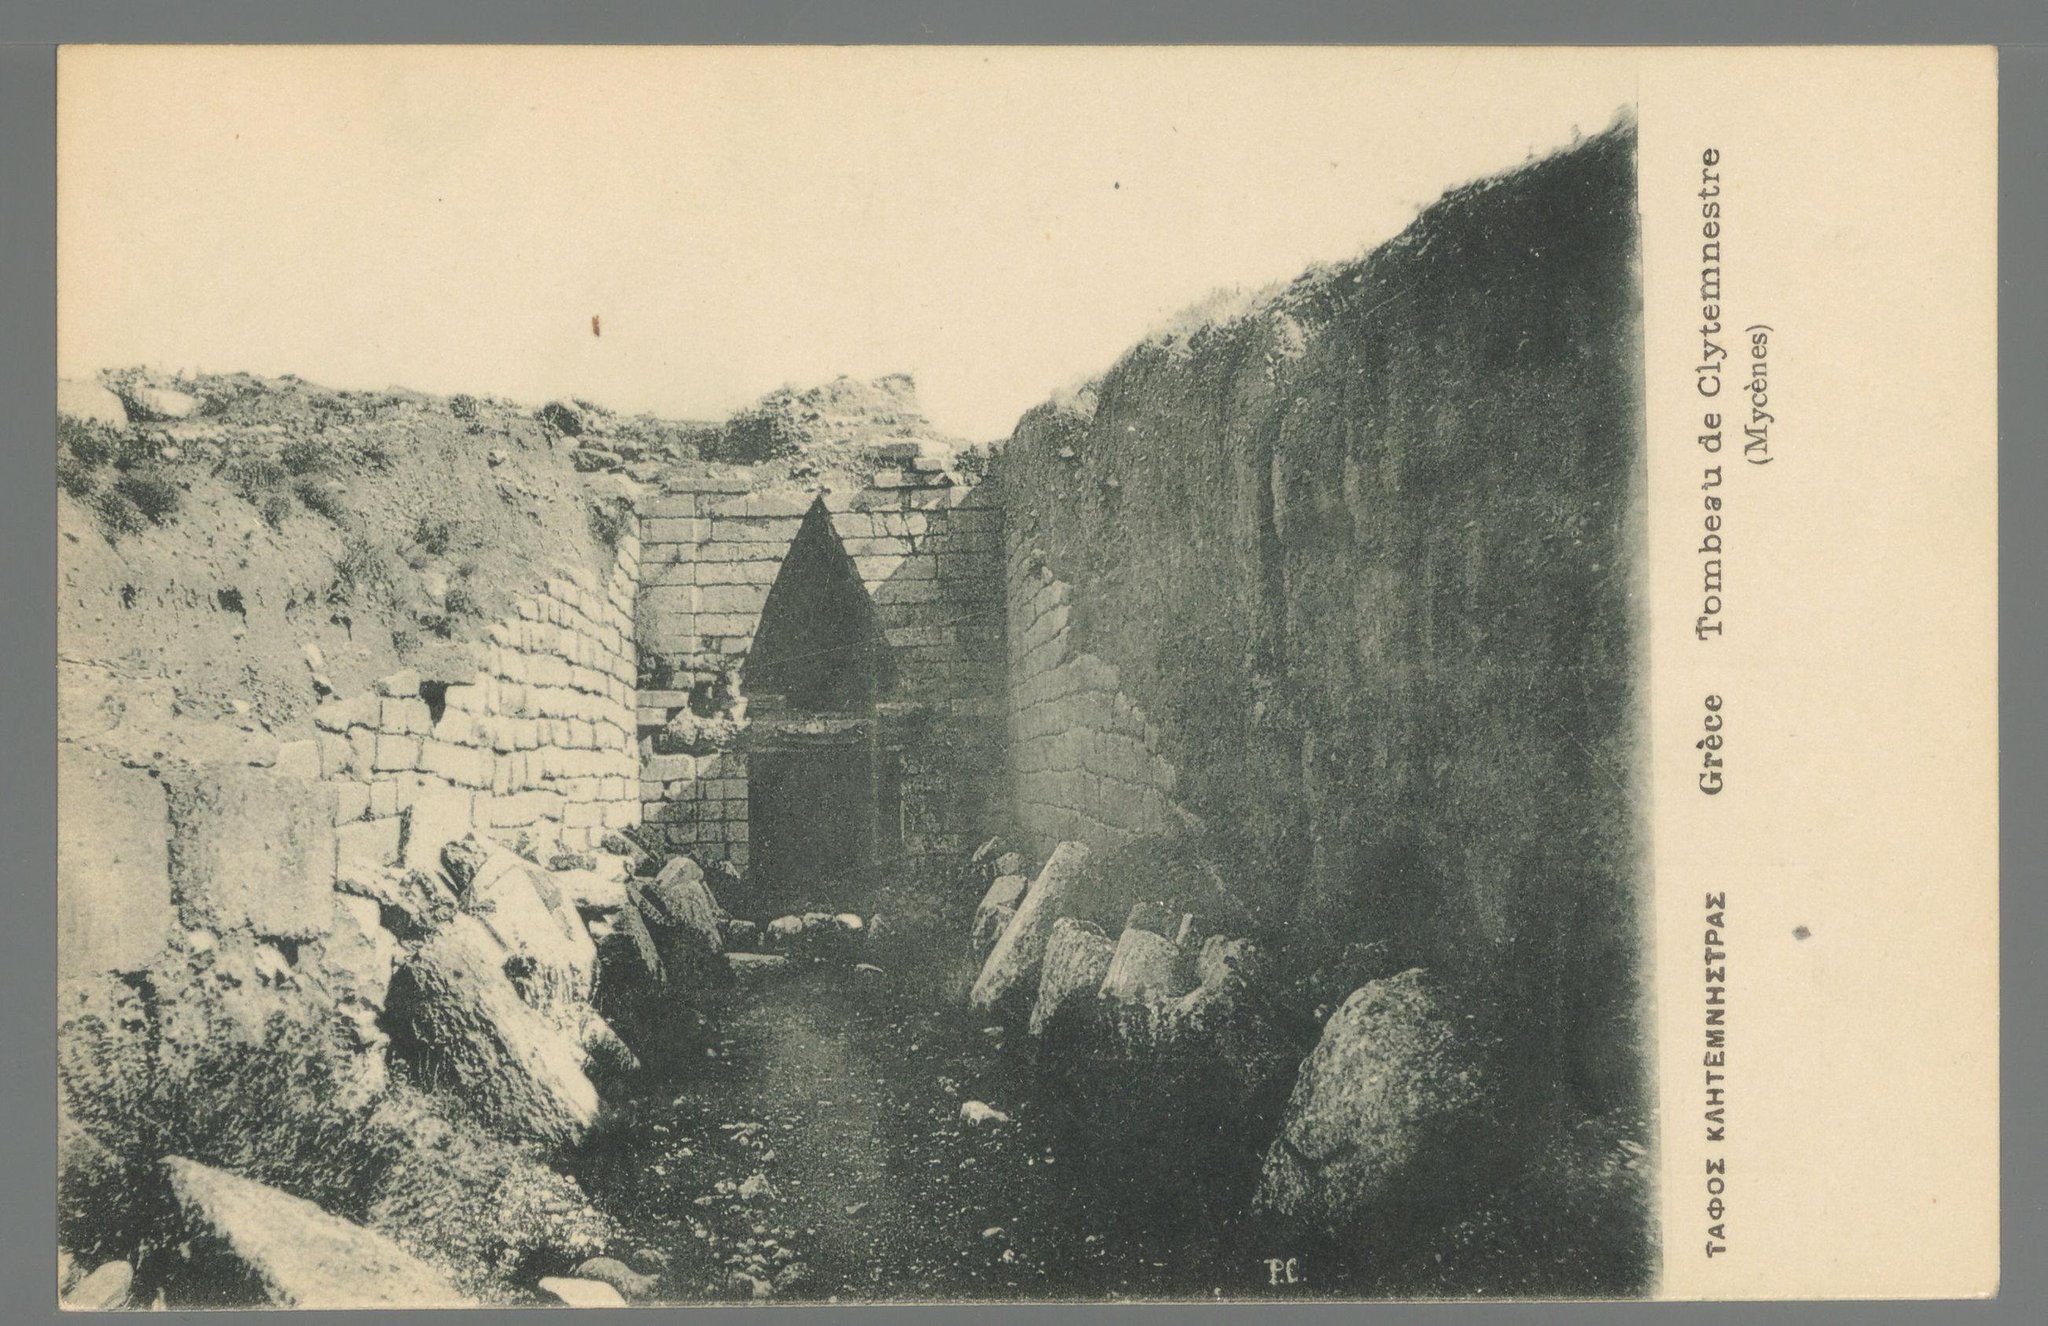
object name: photomechanical print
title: Grèce. Tombeau de Clytemnestre (Mycènes)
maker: Anonymous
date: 1906-1930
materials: cardboard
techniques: photograph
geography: mycene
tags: grave, tomb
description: Voor de Franse titel staat de titel in het Grieks.